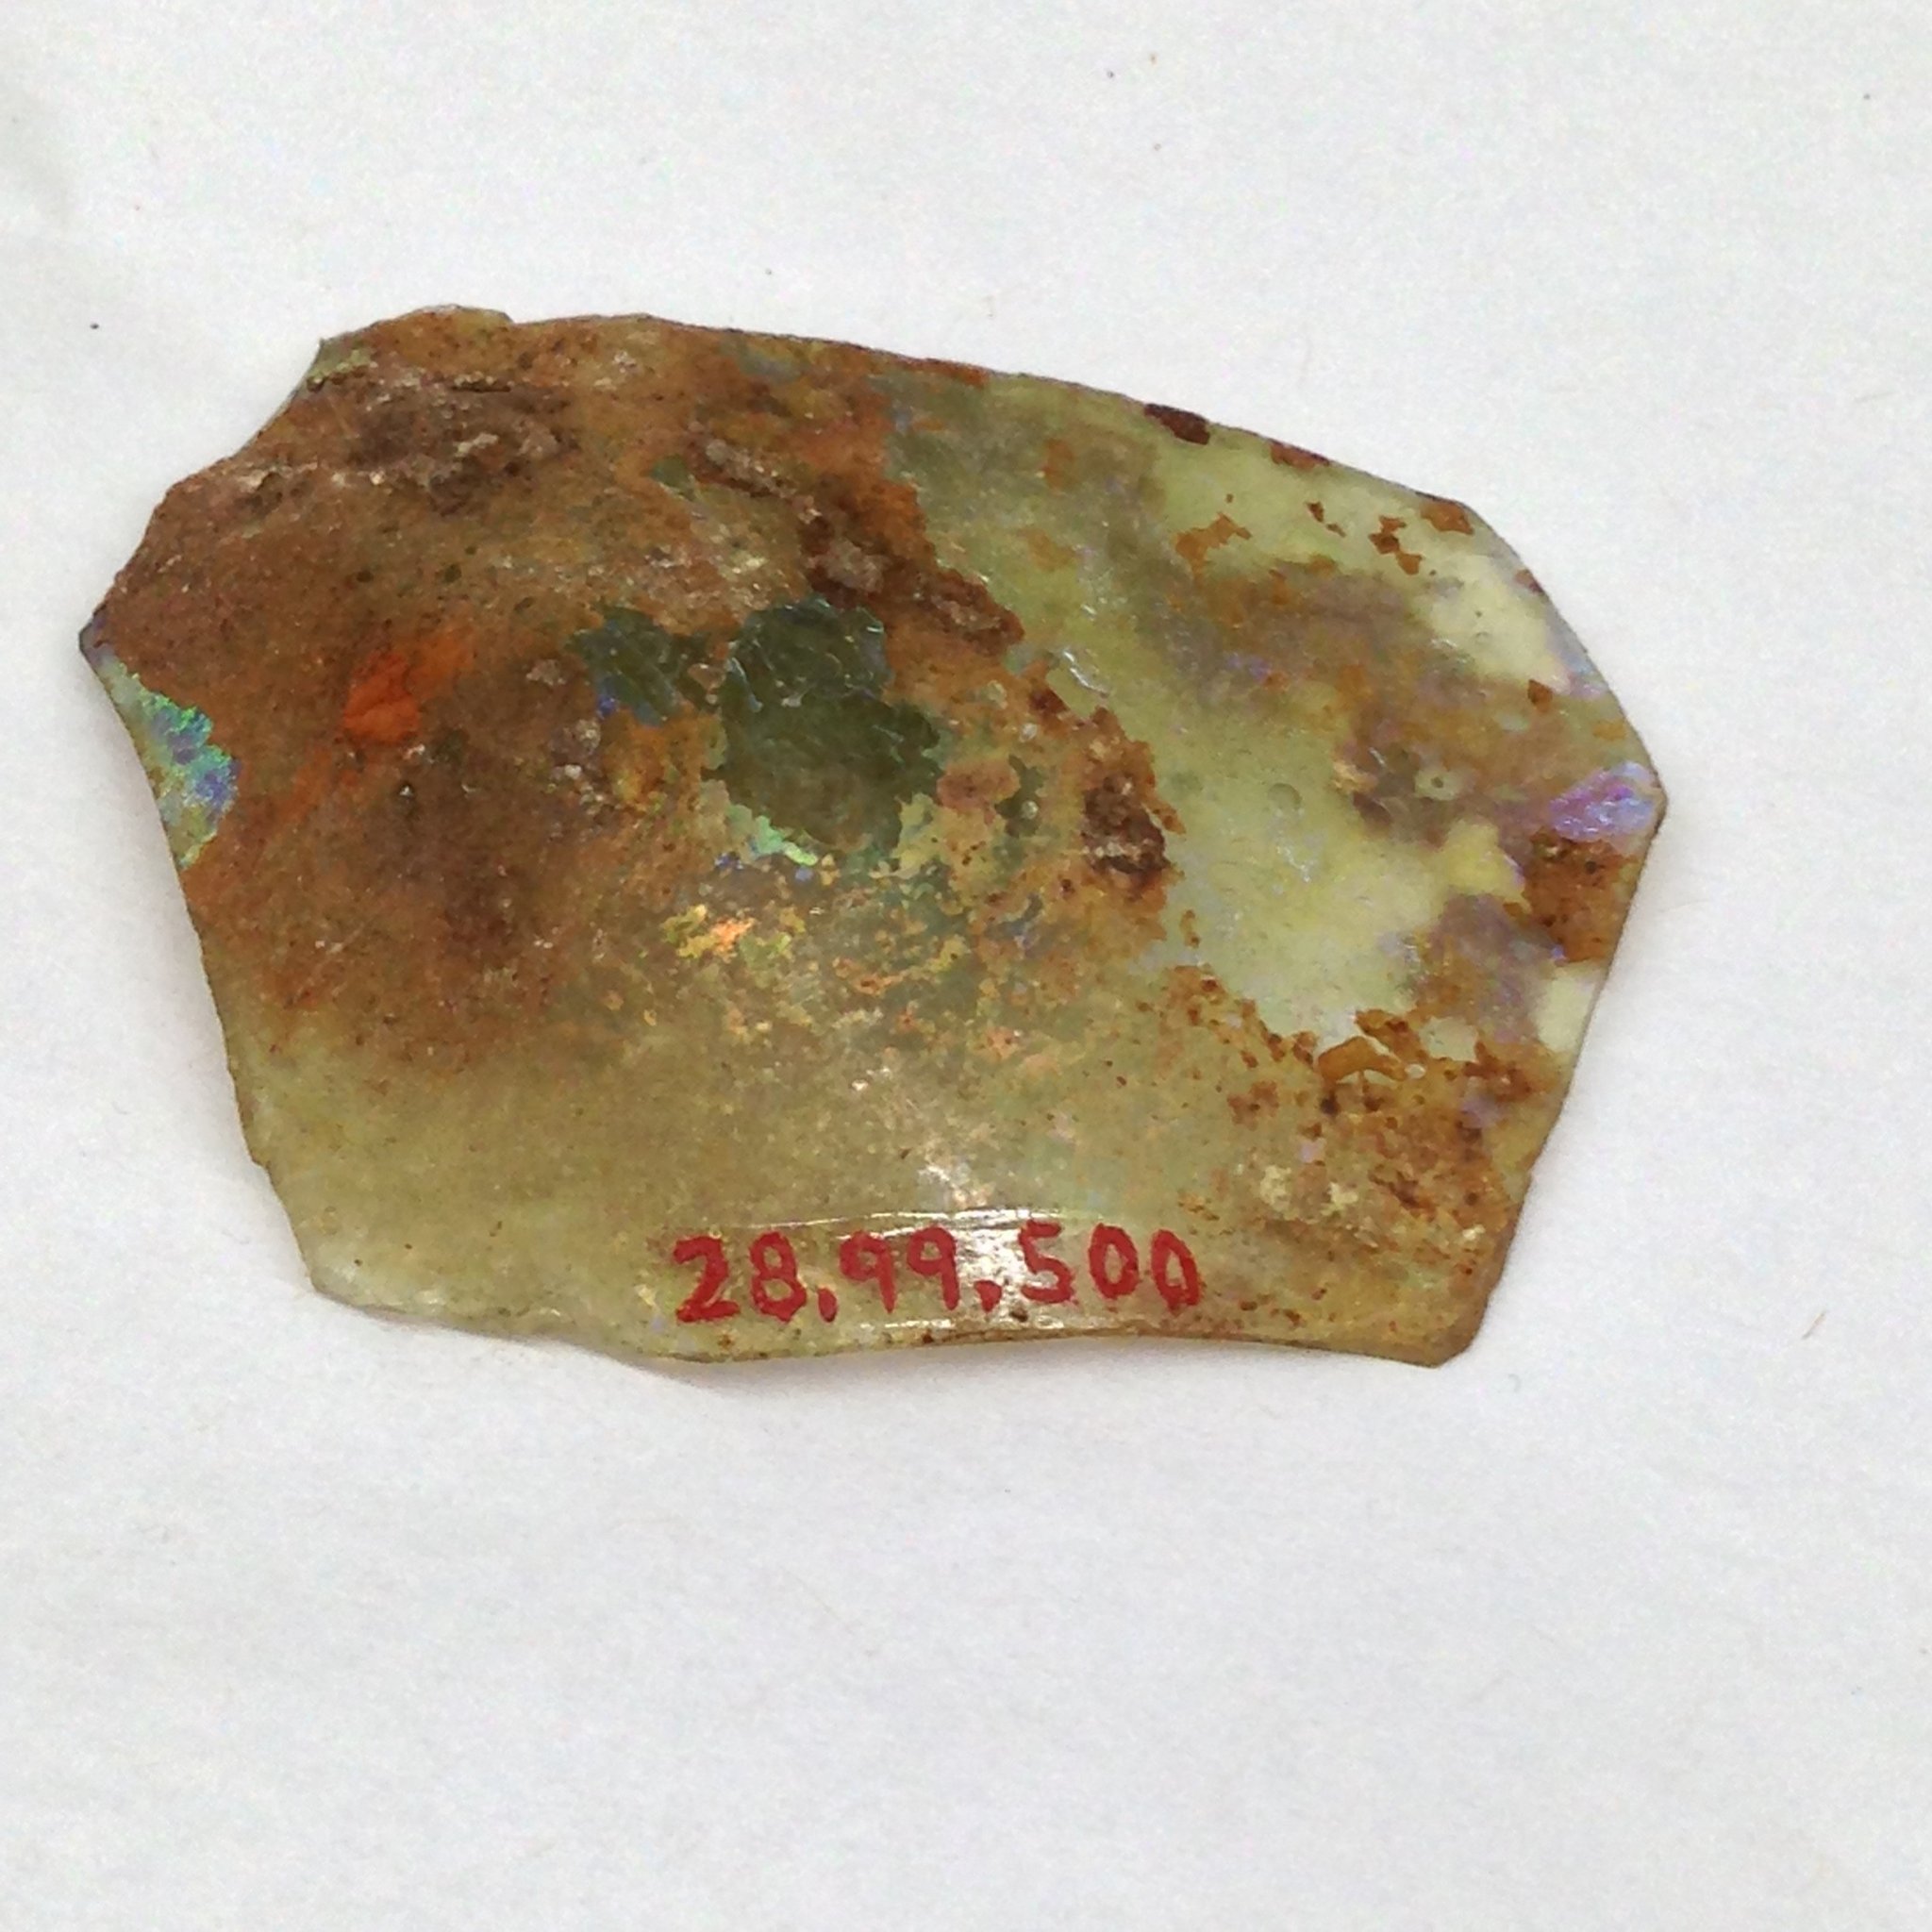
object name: fragment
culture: european or middle eastern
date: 1150-1250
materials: ceramic, glass